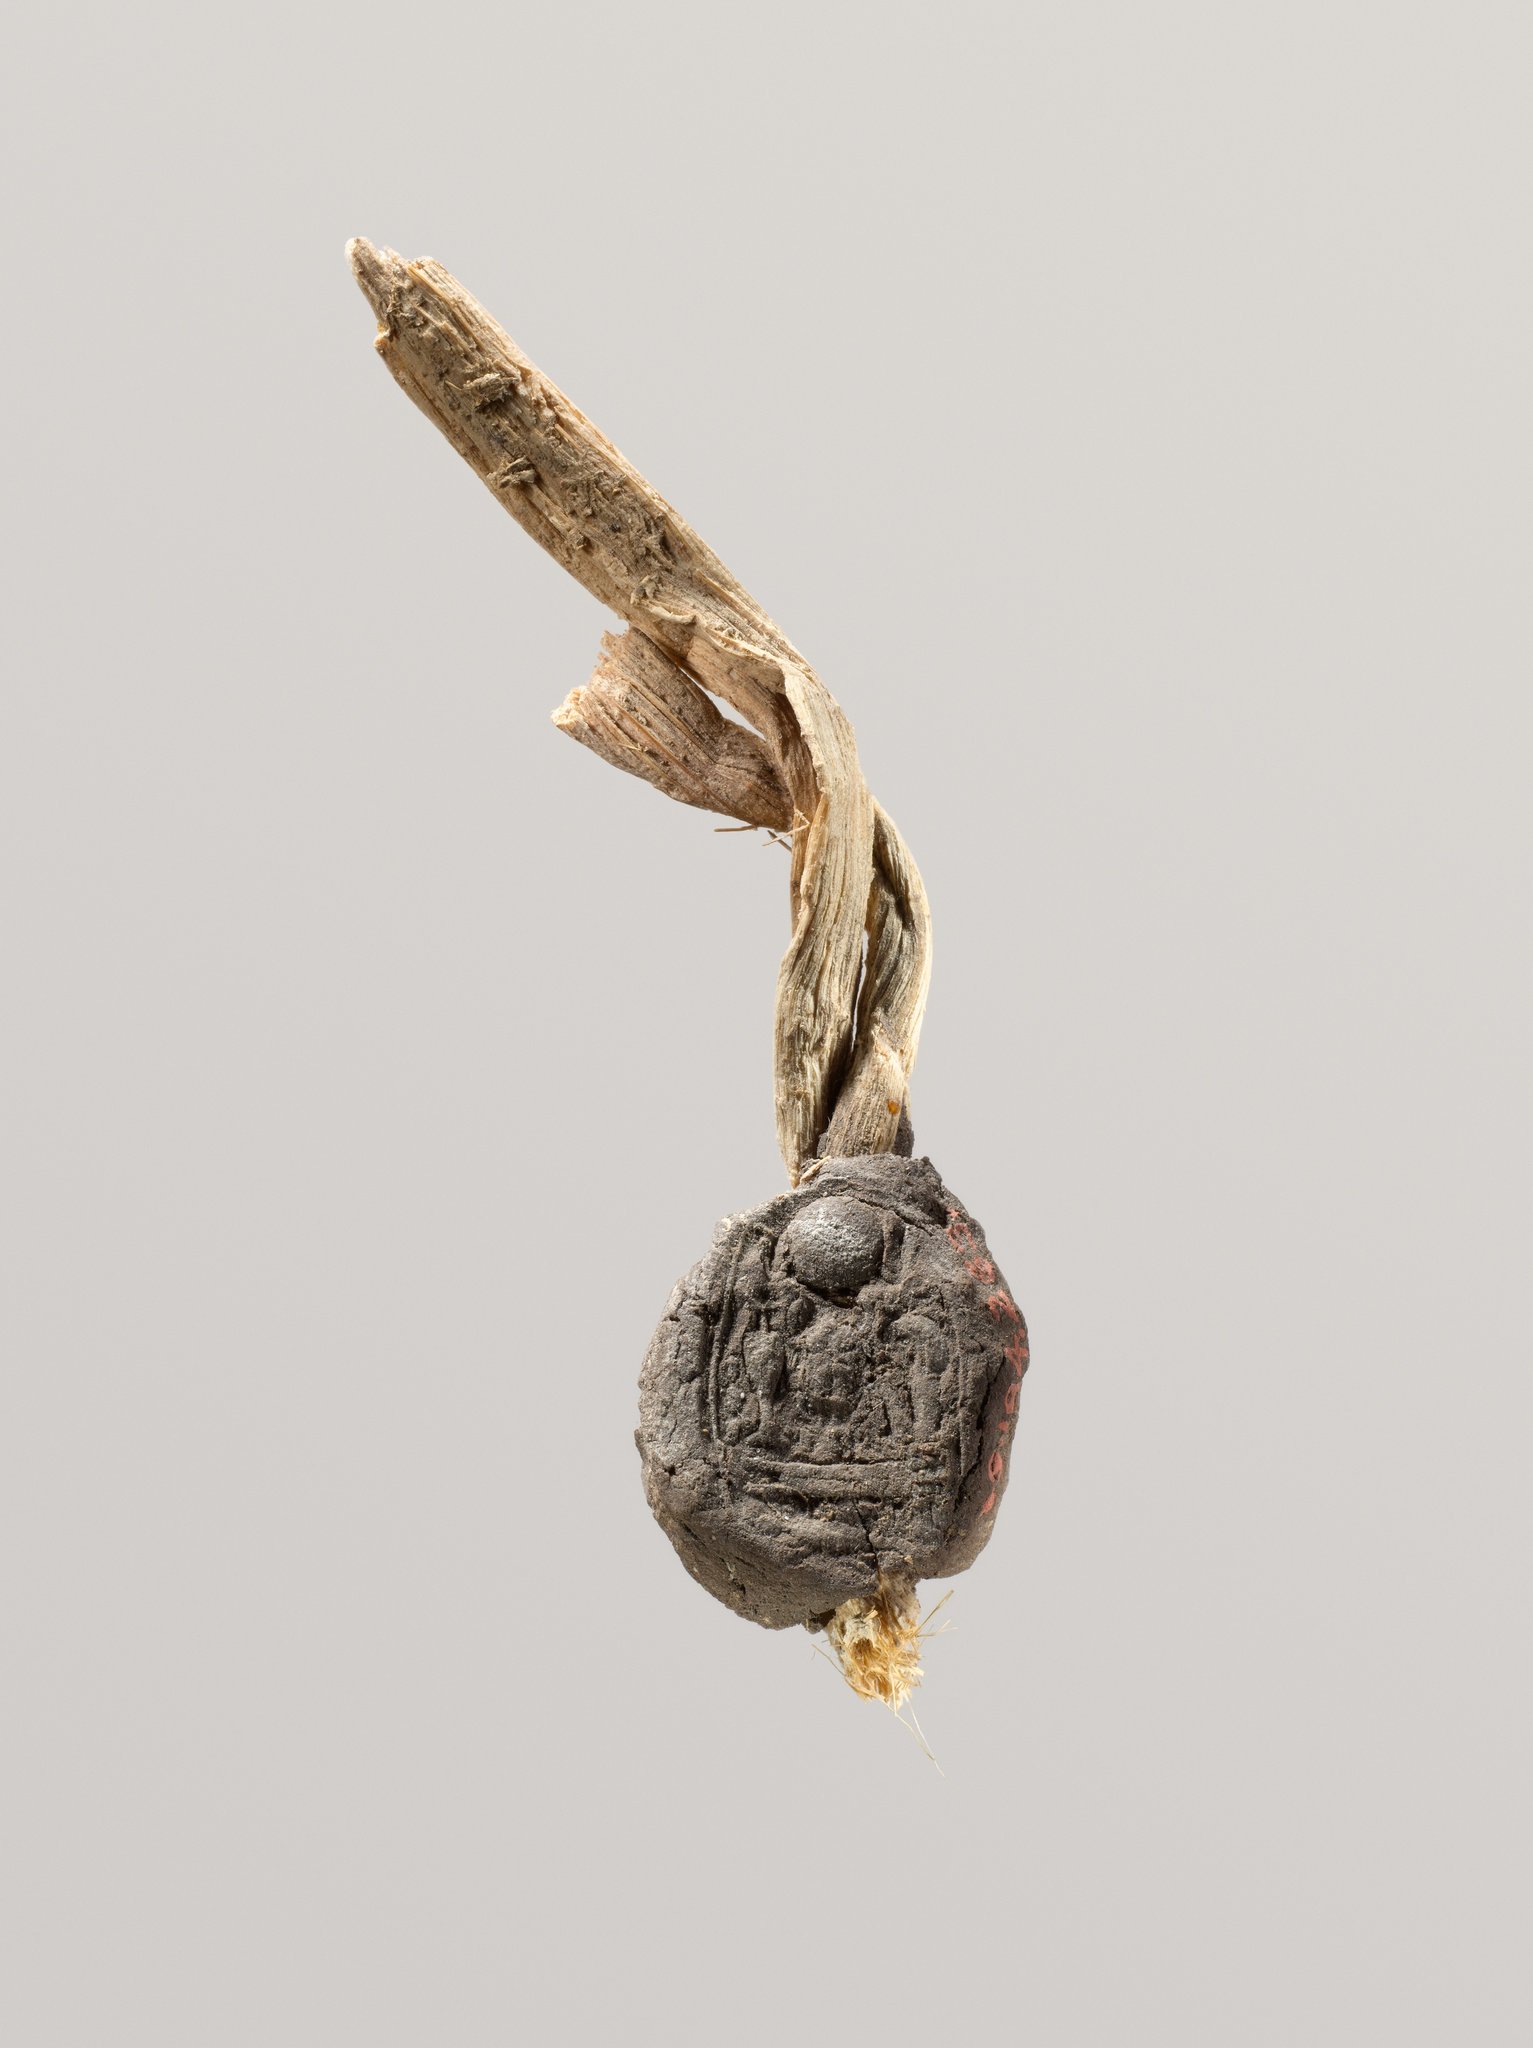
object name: sealing, fiber tie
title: Seal Impression Attatched to a Fiber Tie from Tutankhamun's Embalming Cache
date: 1336-1327 BCE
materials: mud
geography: egypt